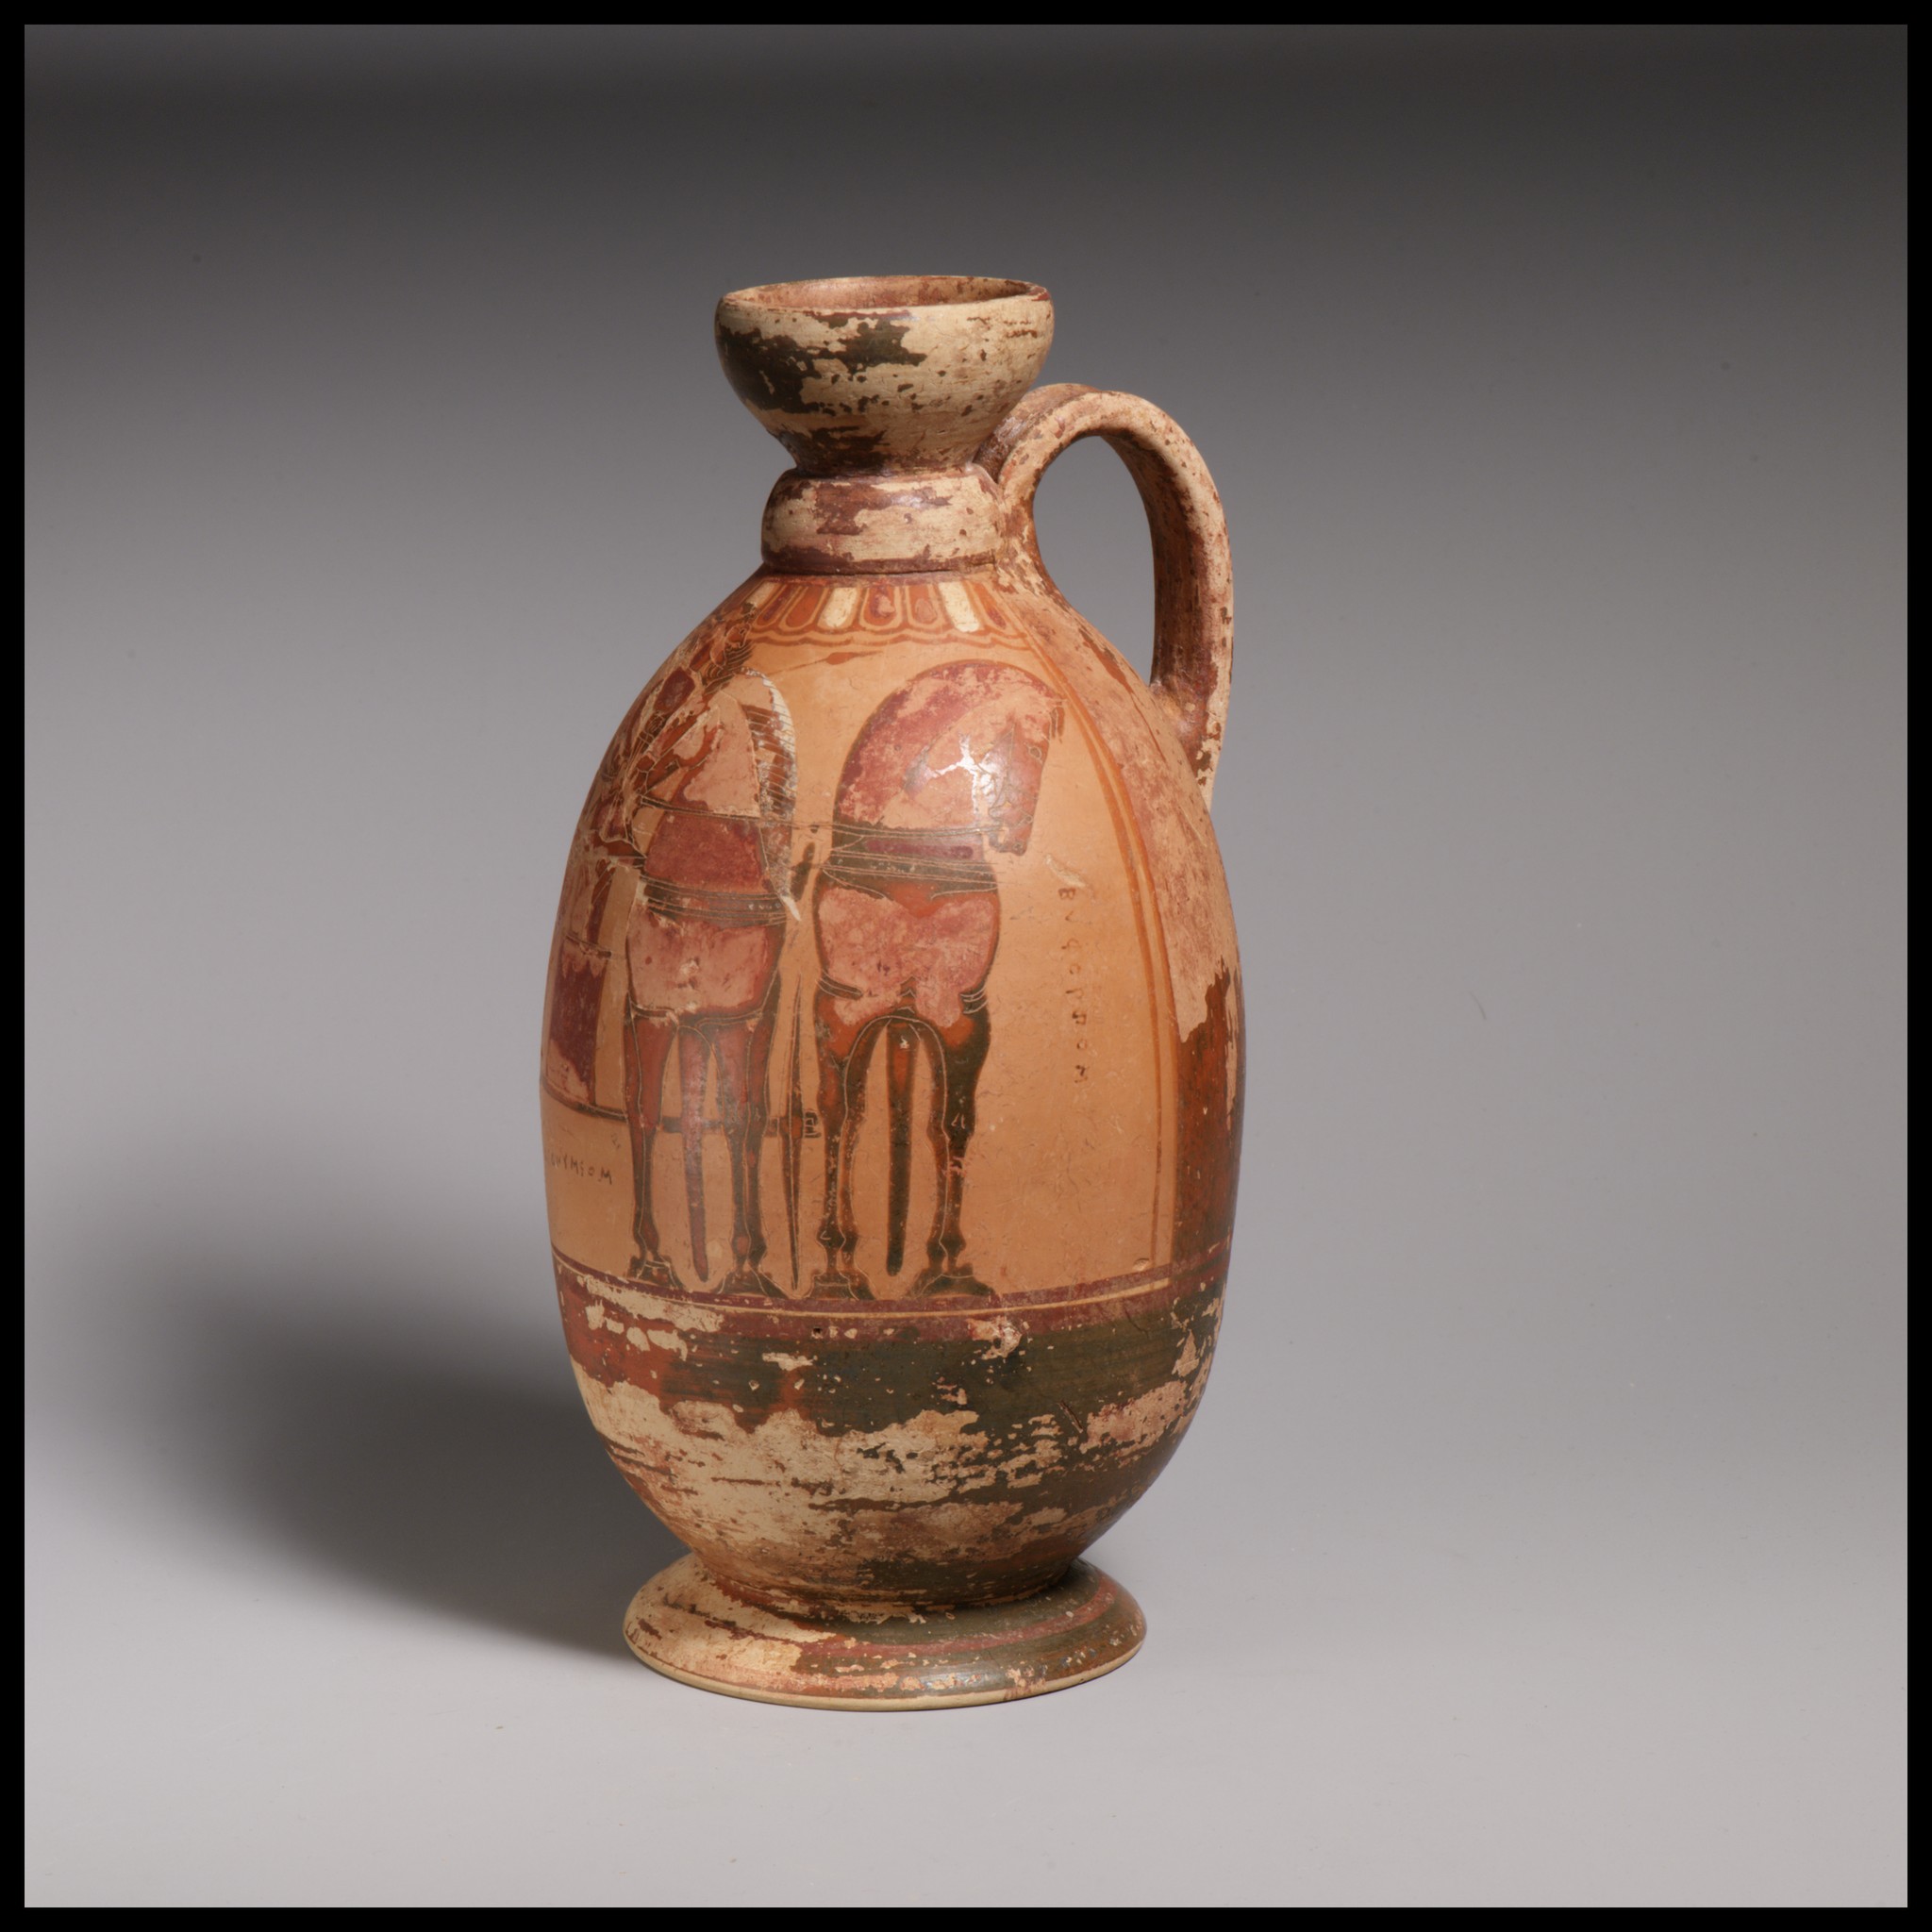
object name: lekythos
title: Terracotta lekythos (oil flask)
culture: greek, corinthian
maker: dionysios painter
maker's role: artist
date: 570-550 BCE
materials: terracotta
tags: horses